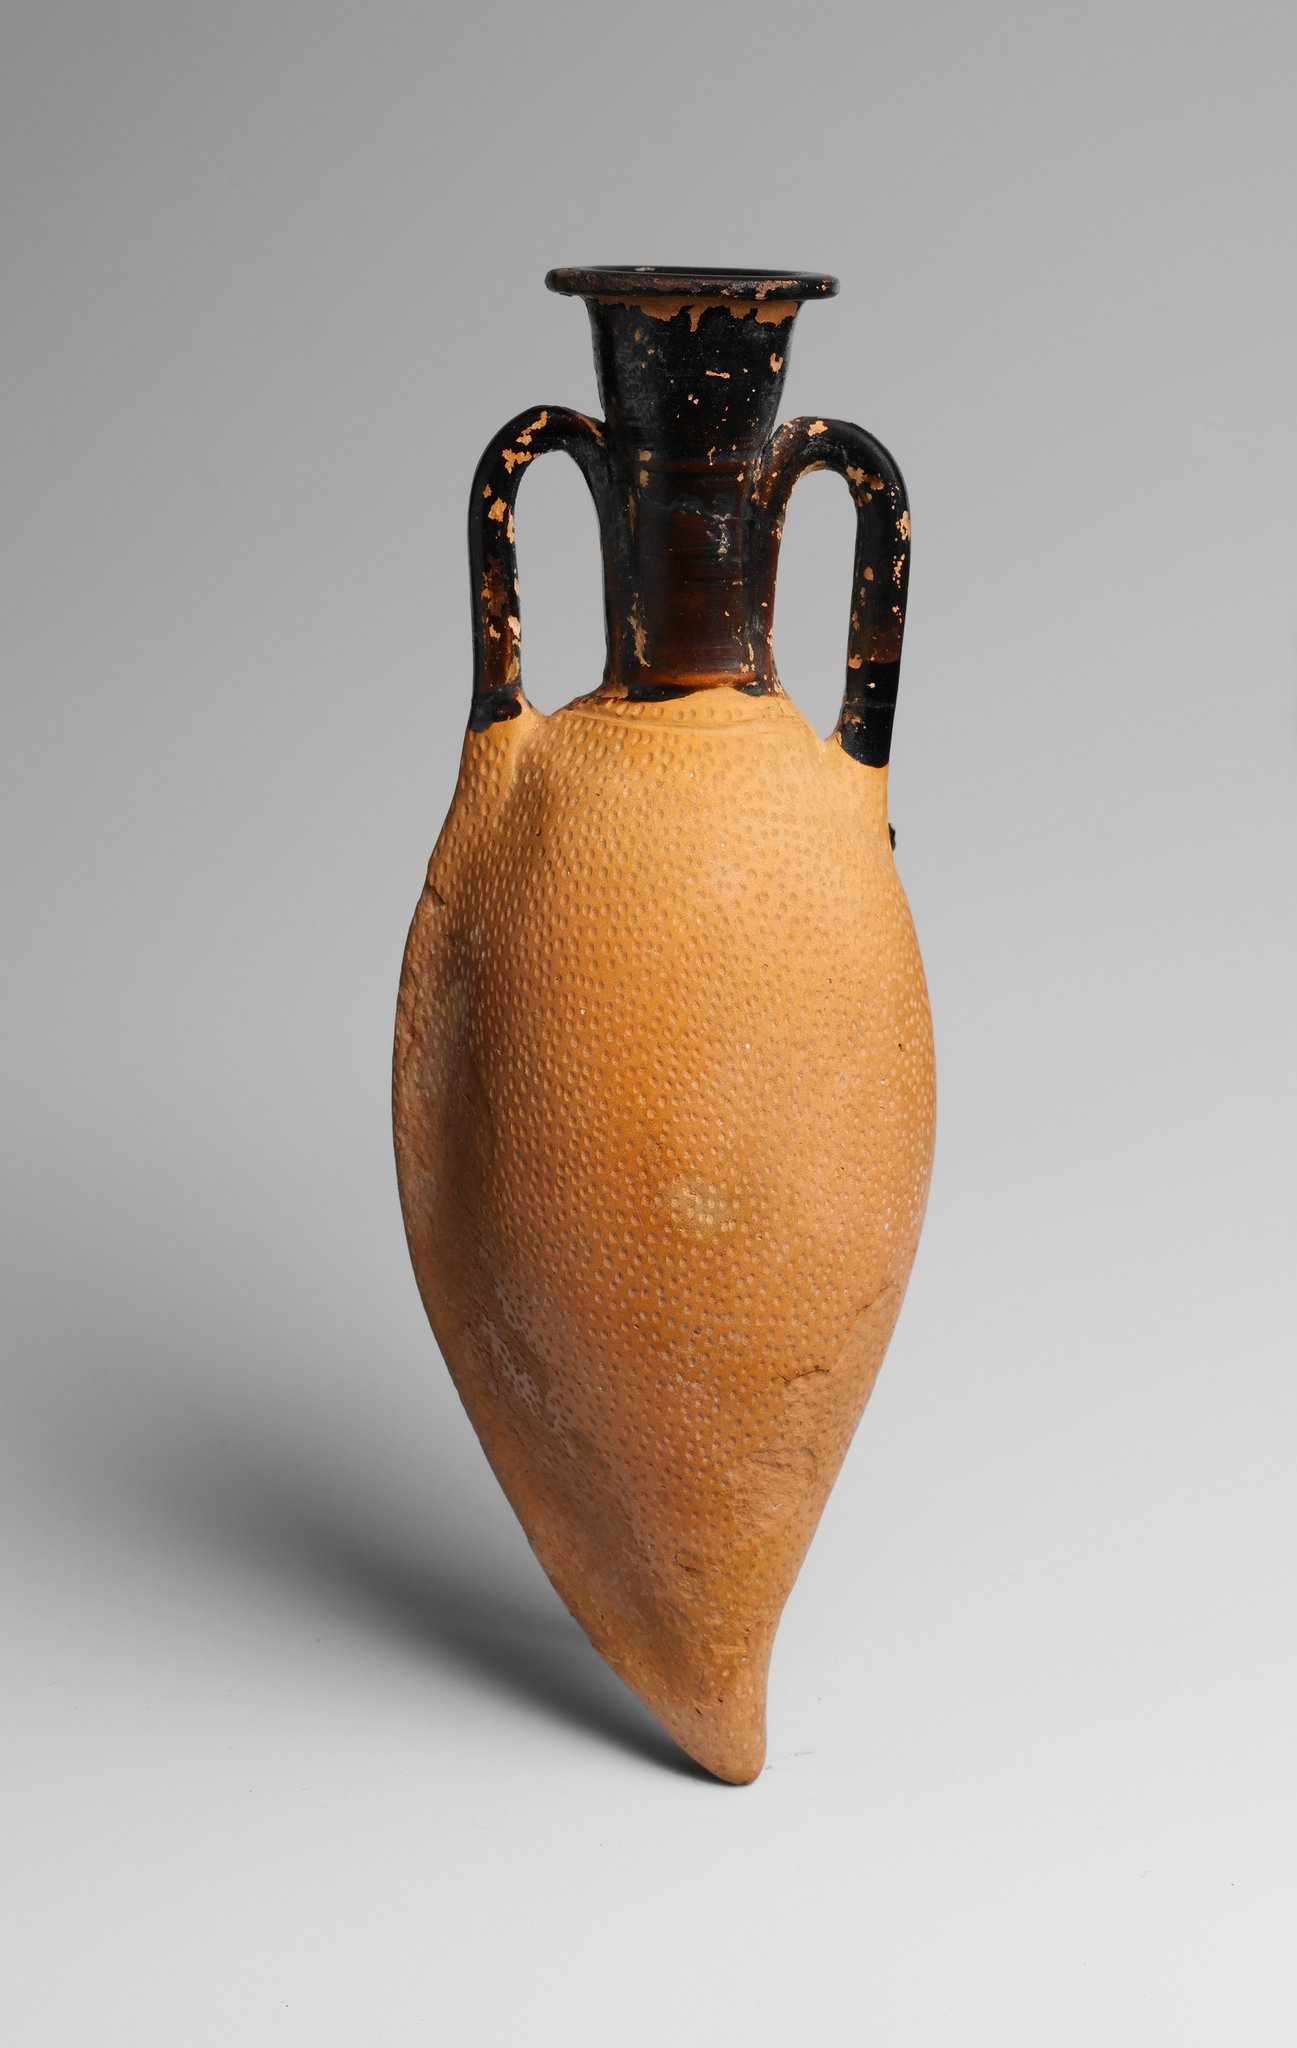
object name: amphoriskos in the form of an almond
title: Terracotta amphoriskos (oil flask)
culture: greek, attic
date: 400-301 BCE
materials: terracotta